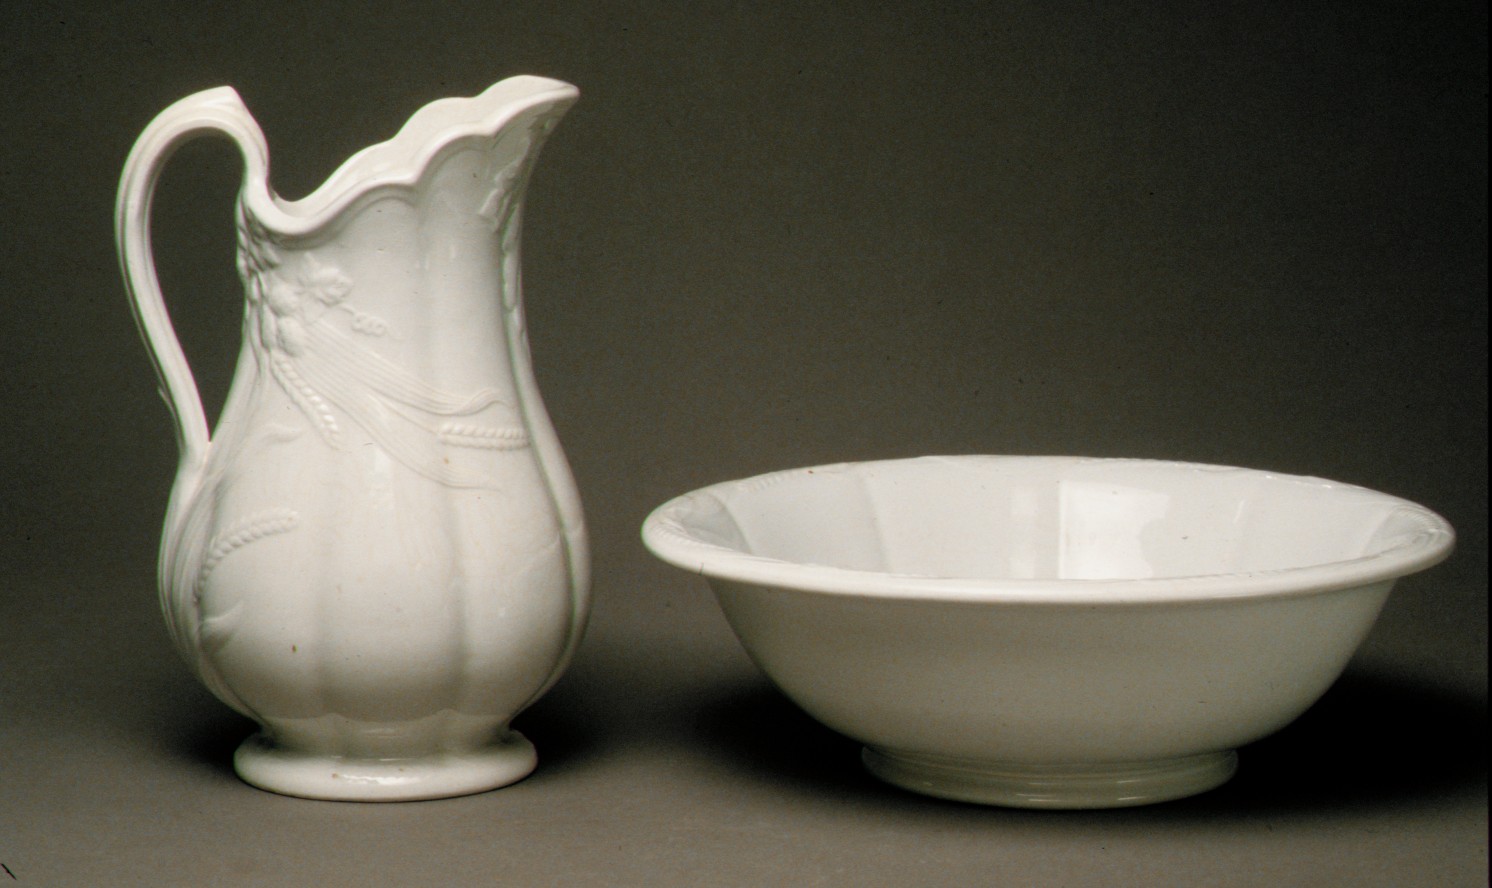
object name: basin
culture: british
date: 1857-1890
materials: earthenware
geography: england